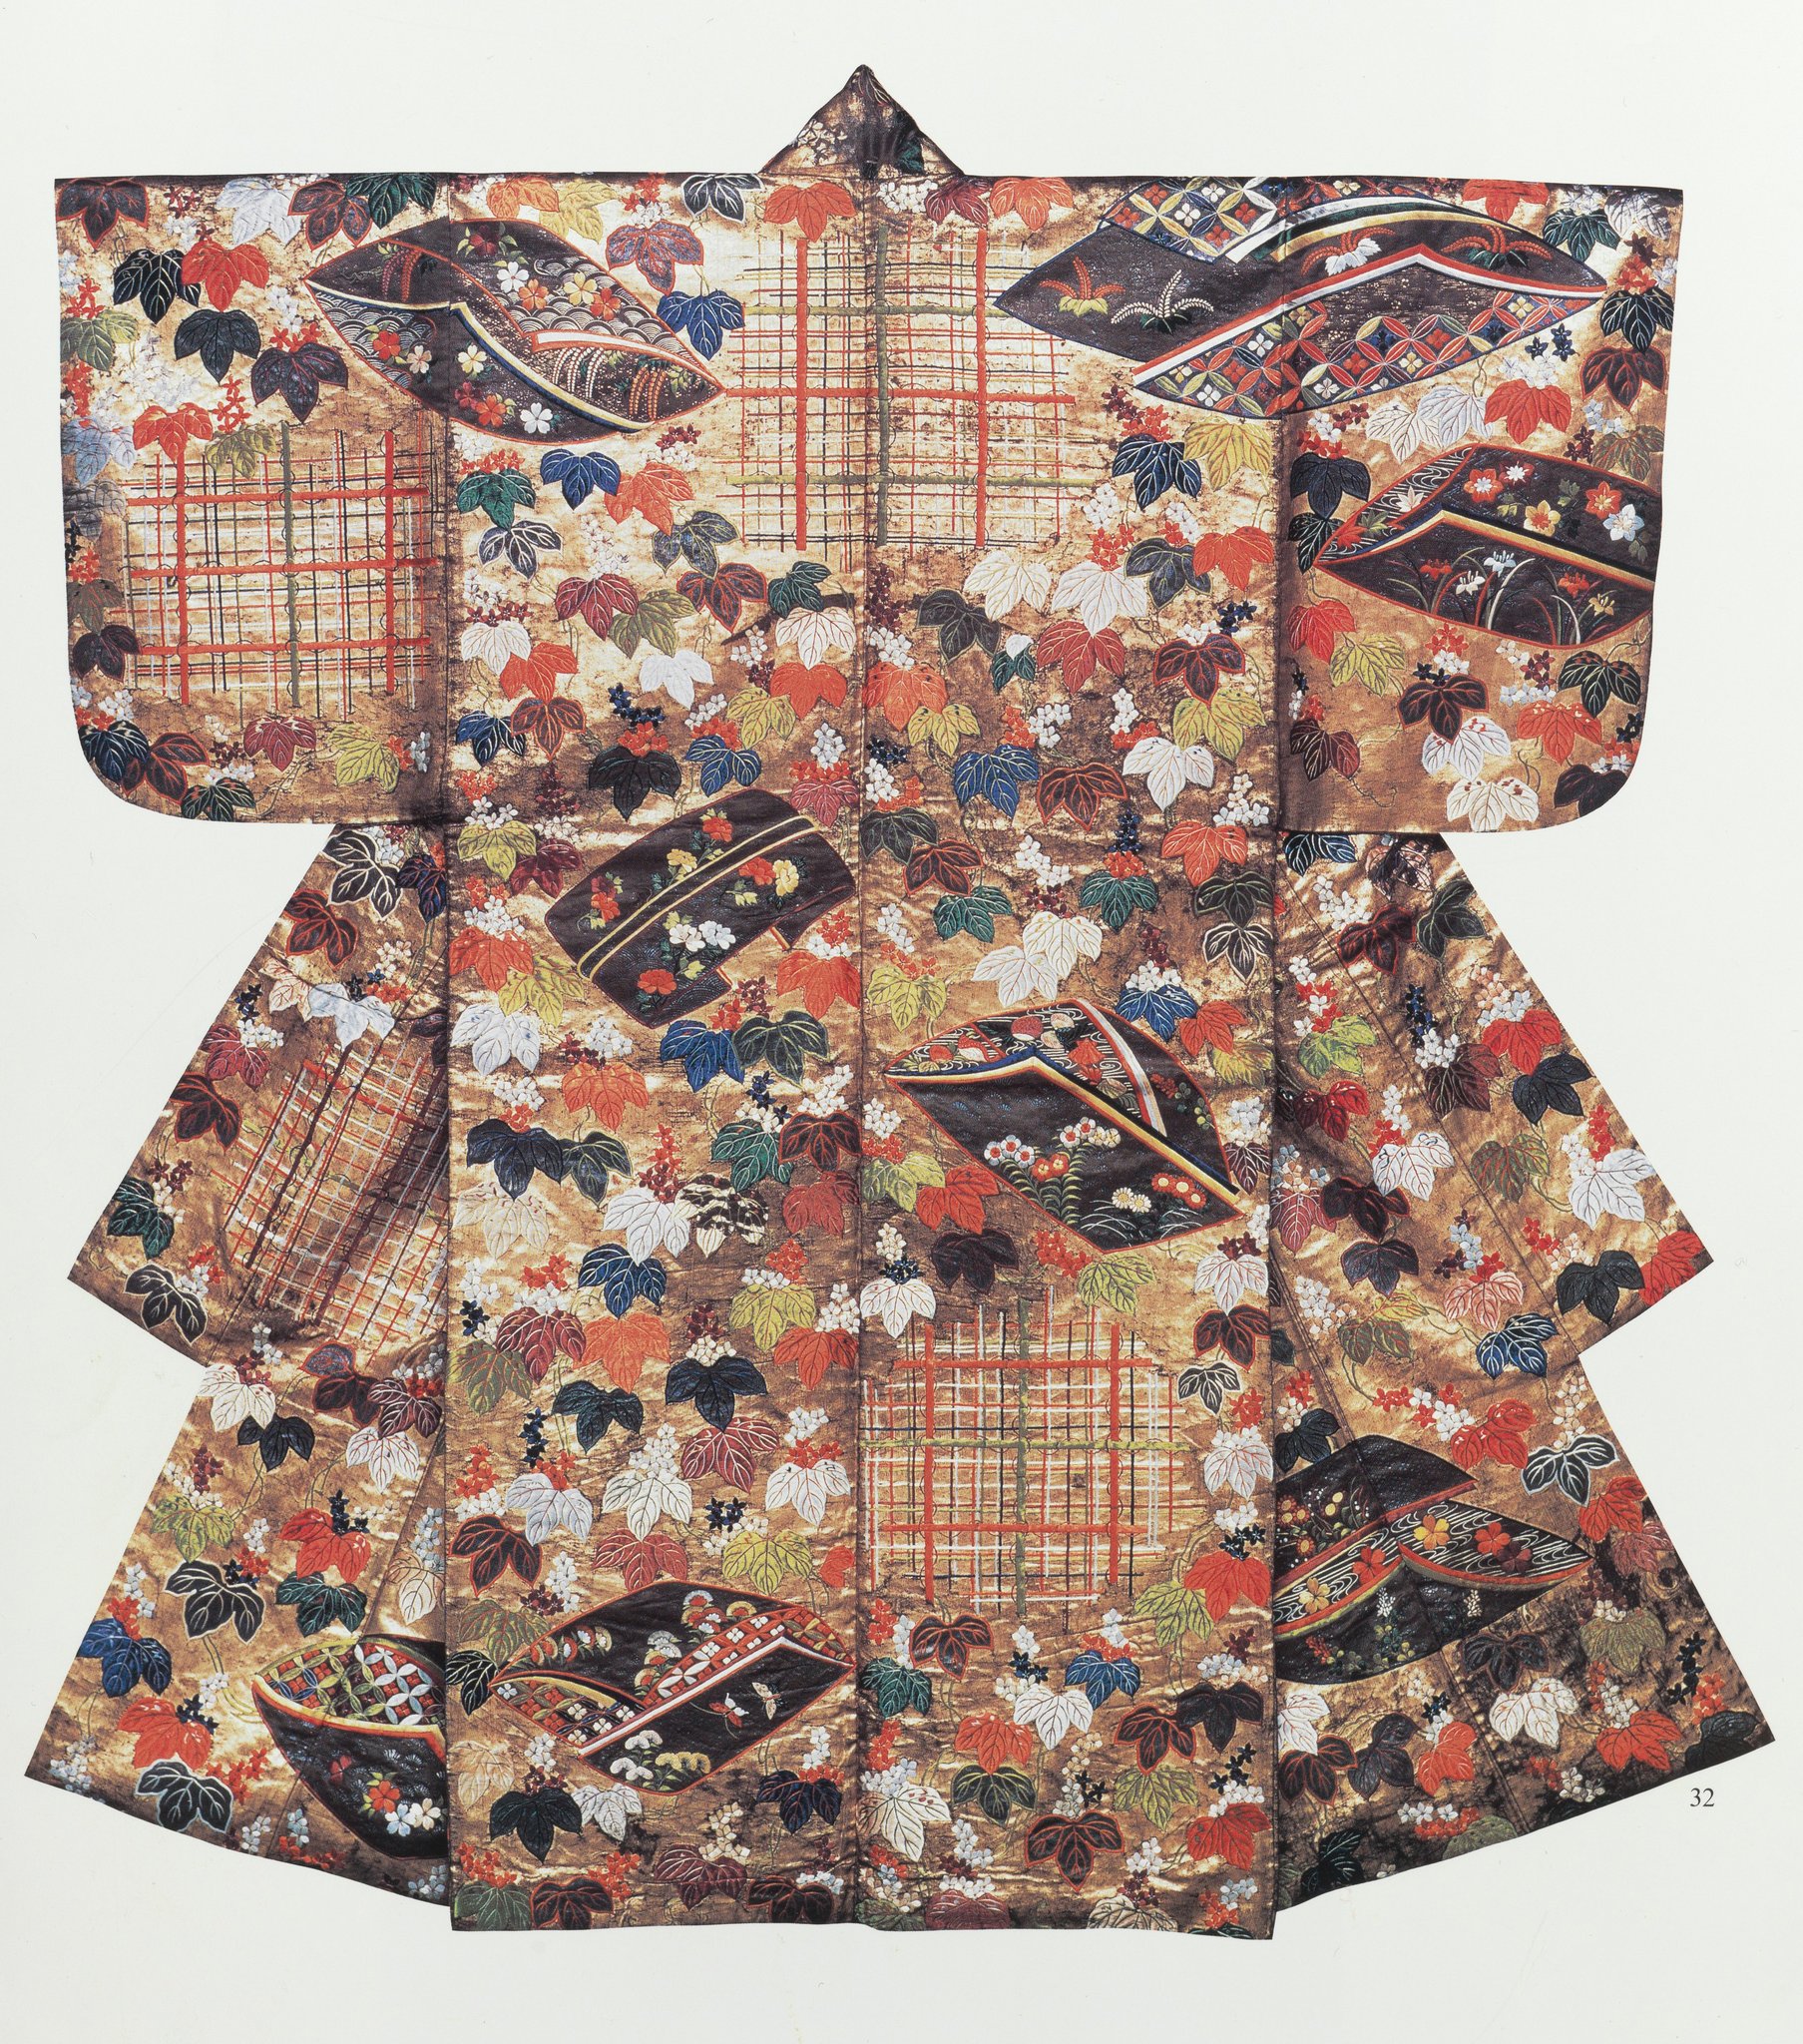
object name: noh costume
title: Noh Costume (Nuihaku) with Ivy, Incense Wrappers, and Bamboo Blinds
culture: japanese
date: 1701-1750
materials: gold leaf, silk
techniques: embroidery